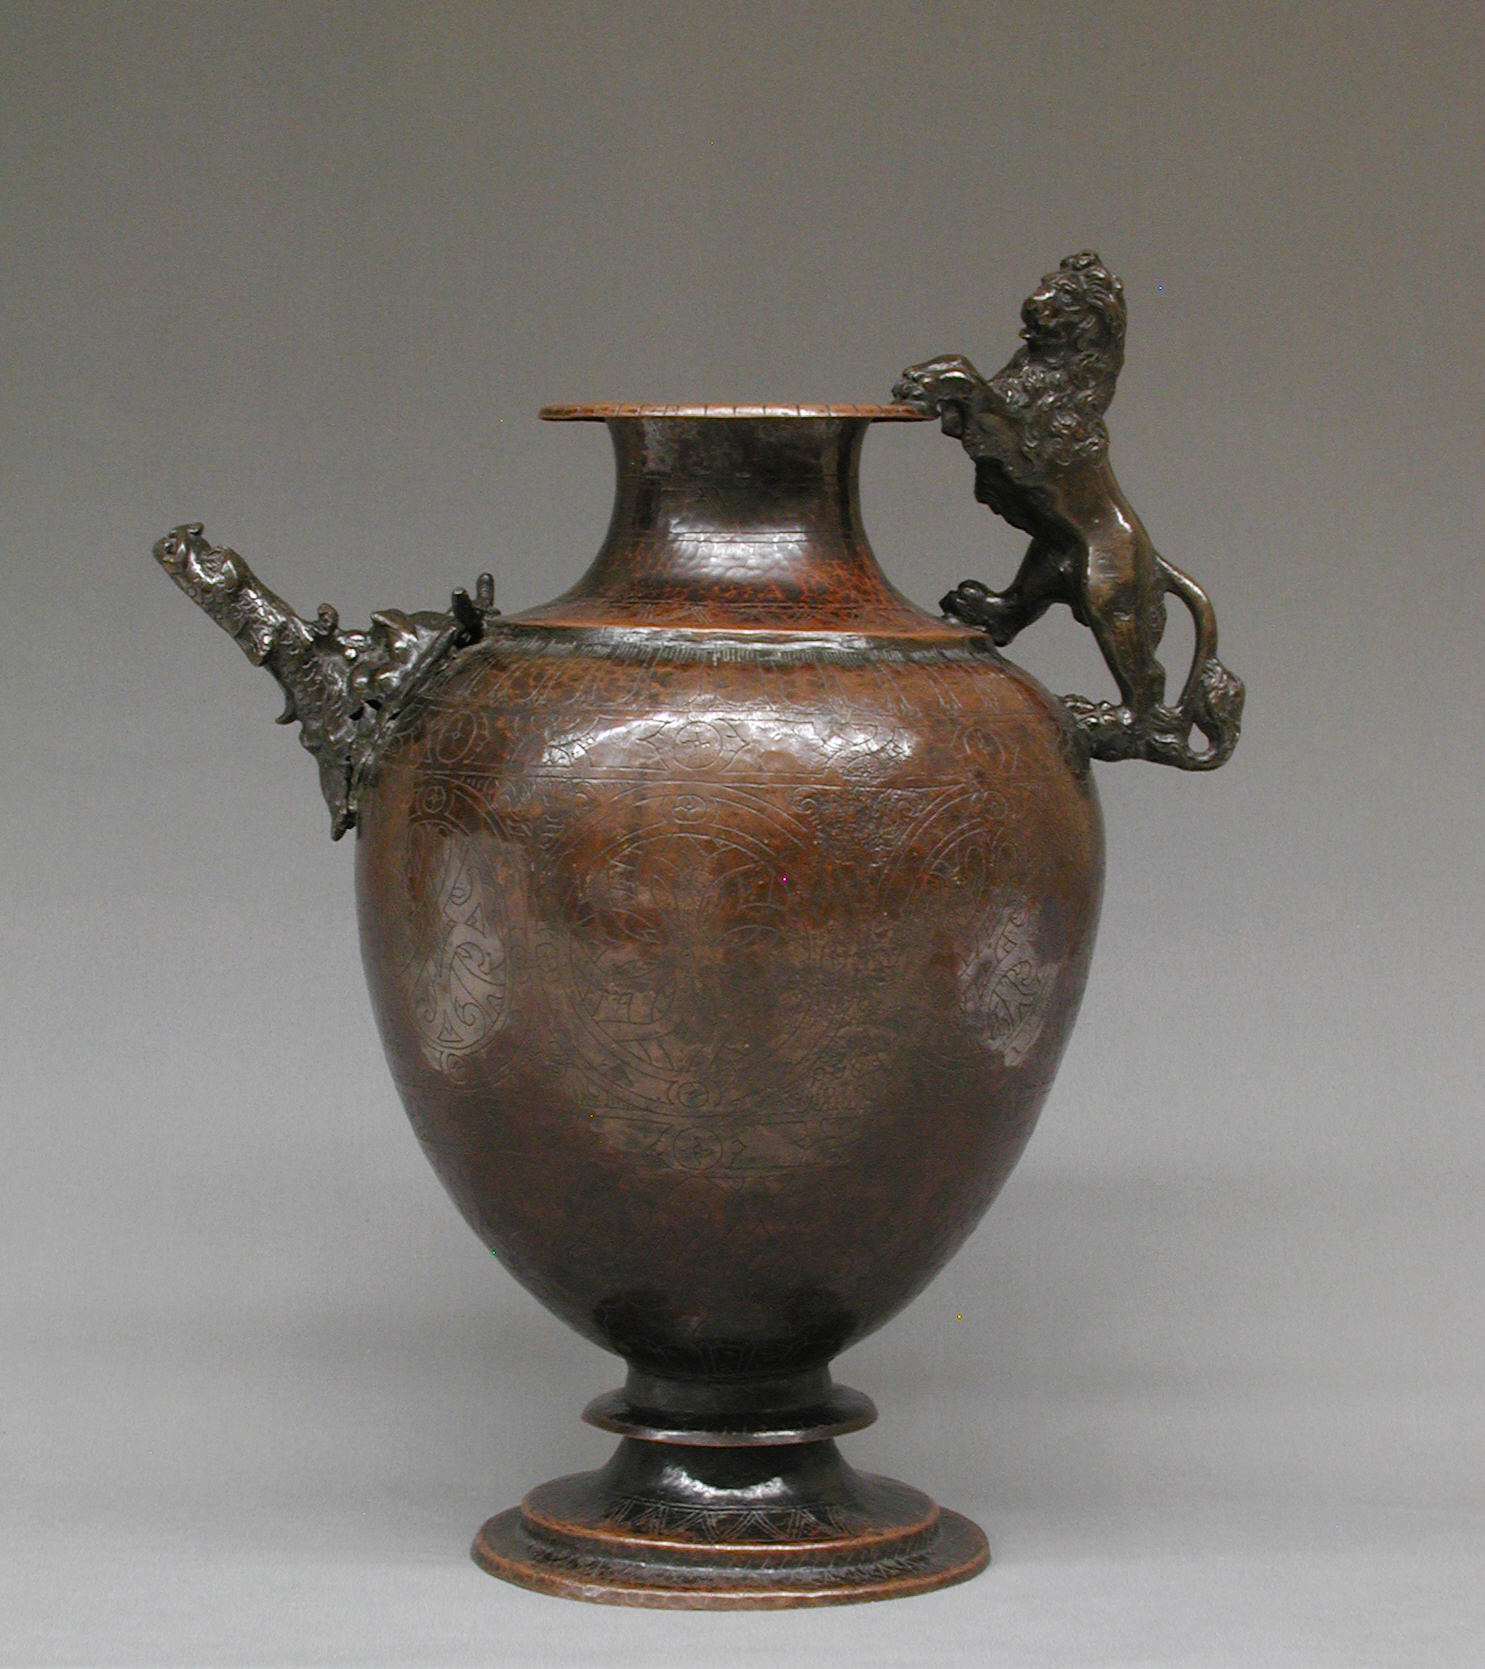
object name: ewer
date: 1551-1600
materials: bronze, copper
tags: lions